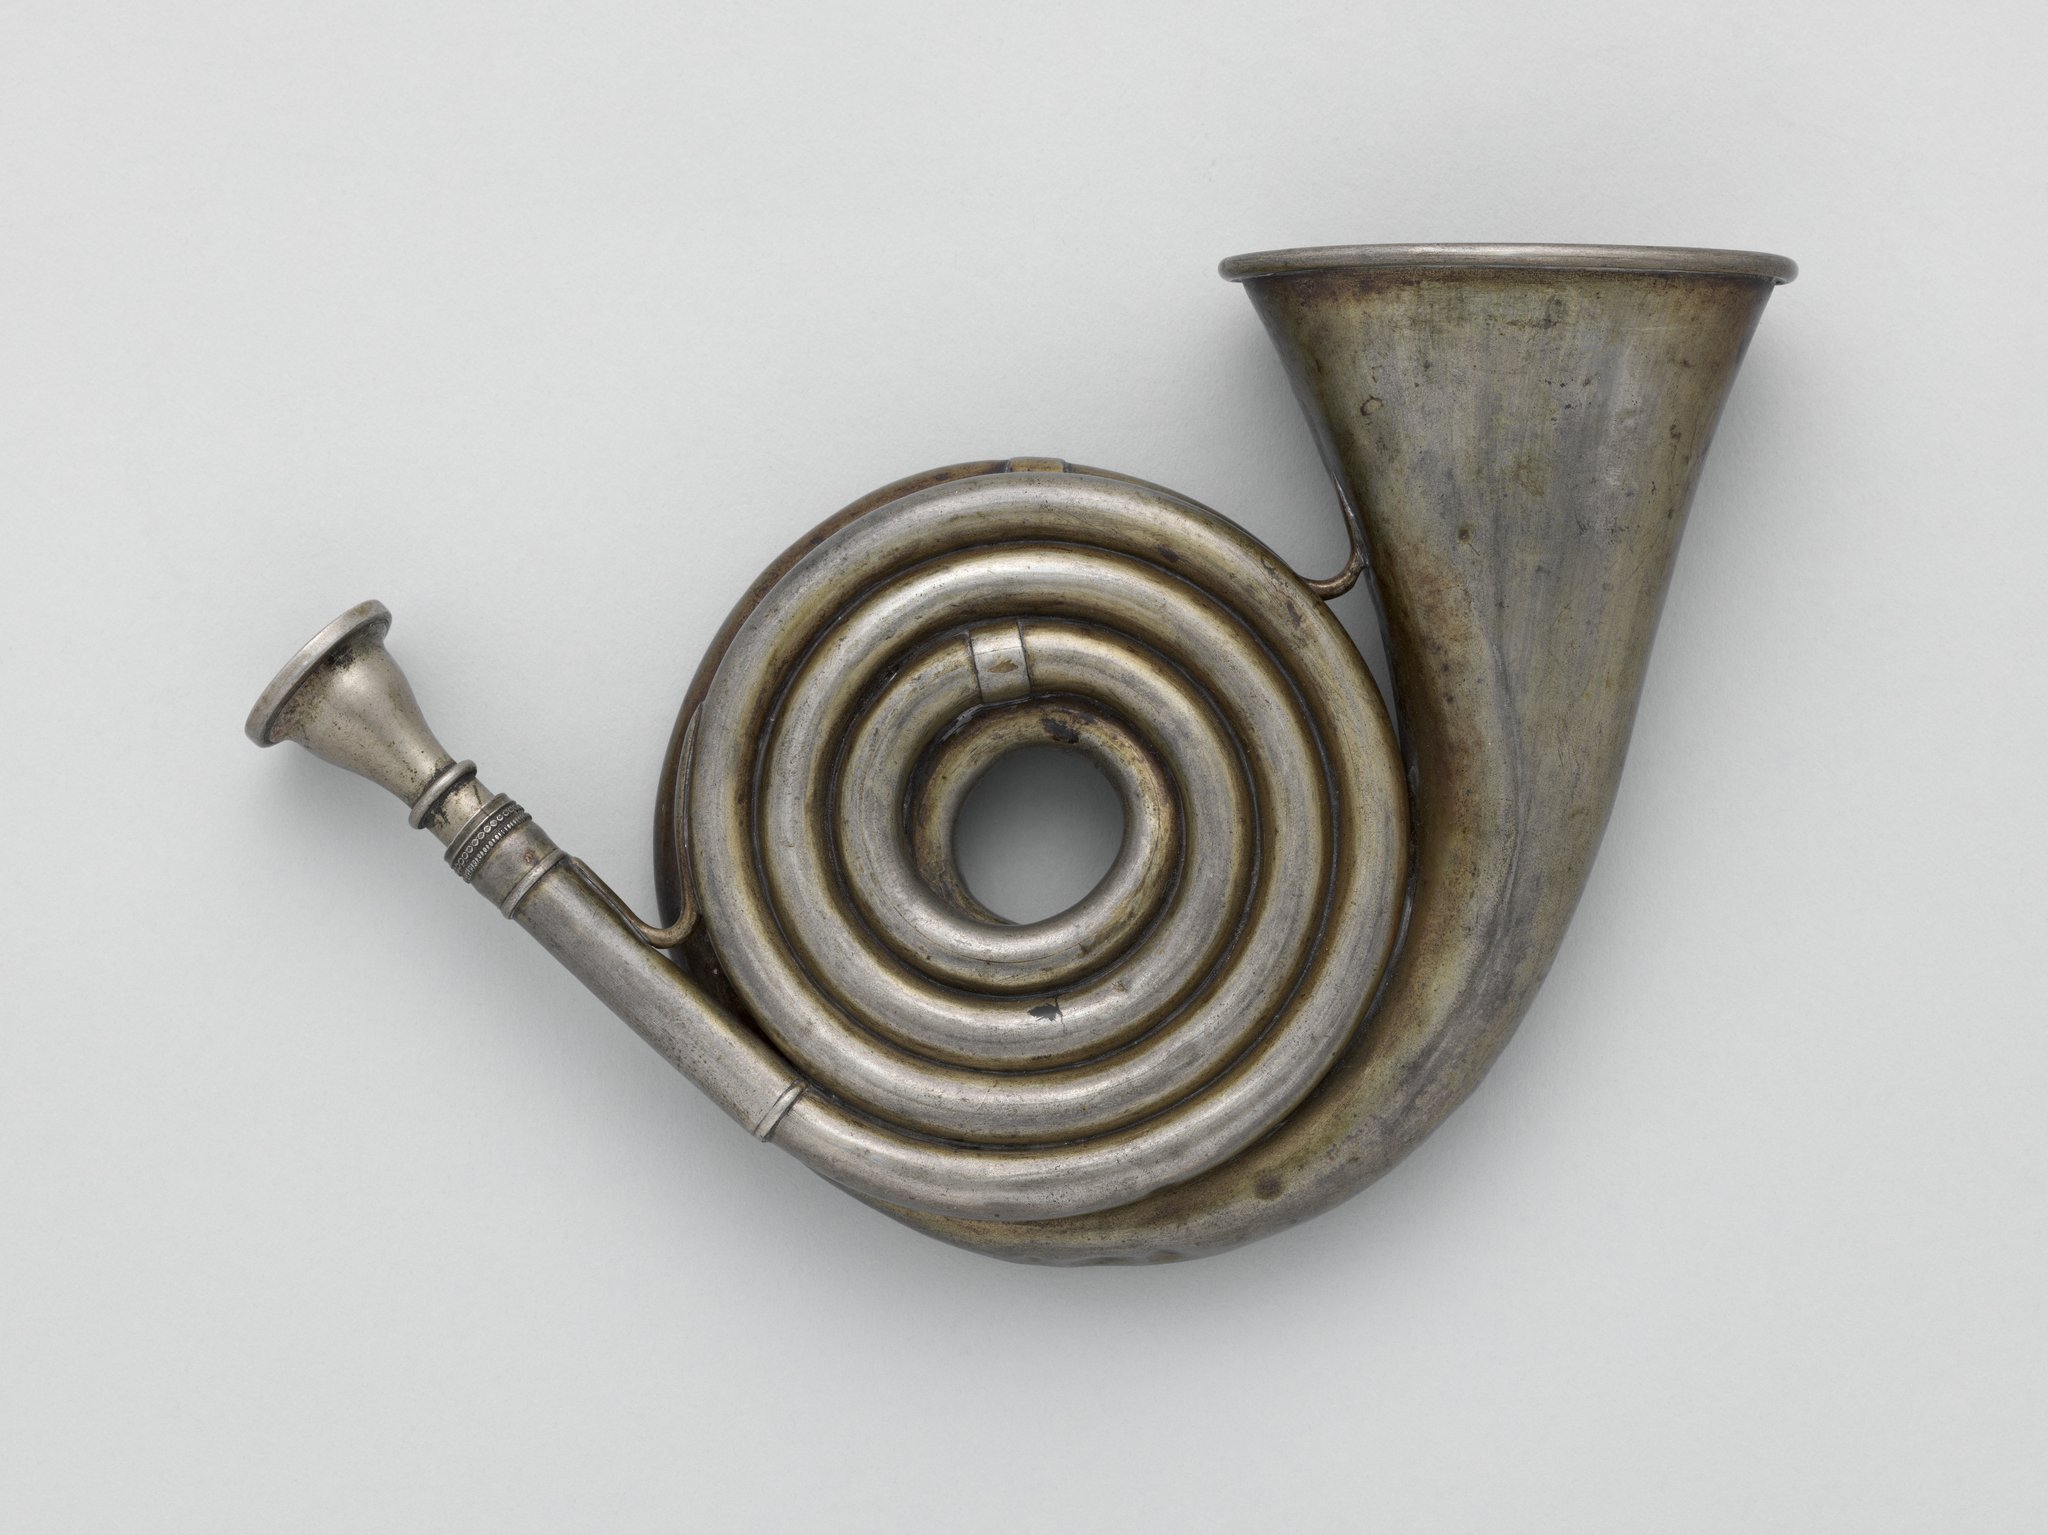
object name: pocket hunting horn in g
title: Pocket Post Horn in G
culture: italian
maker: giuseppe pelitti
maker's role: maker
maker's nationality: italian, born varese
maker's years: 1811-1865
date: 1880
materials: nickel, silver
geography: italy